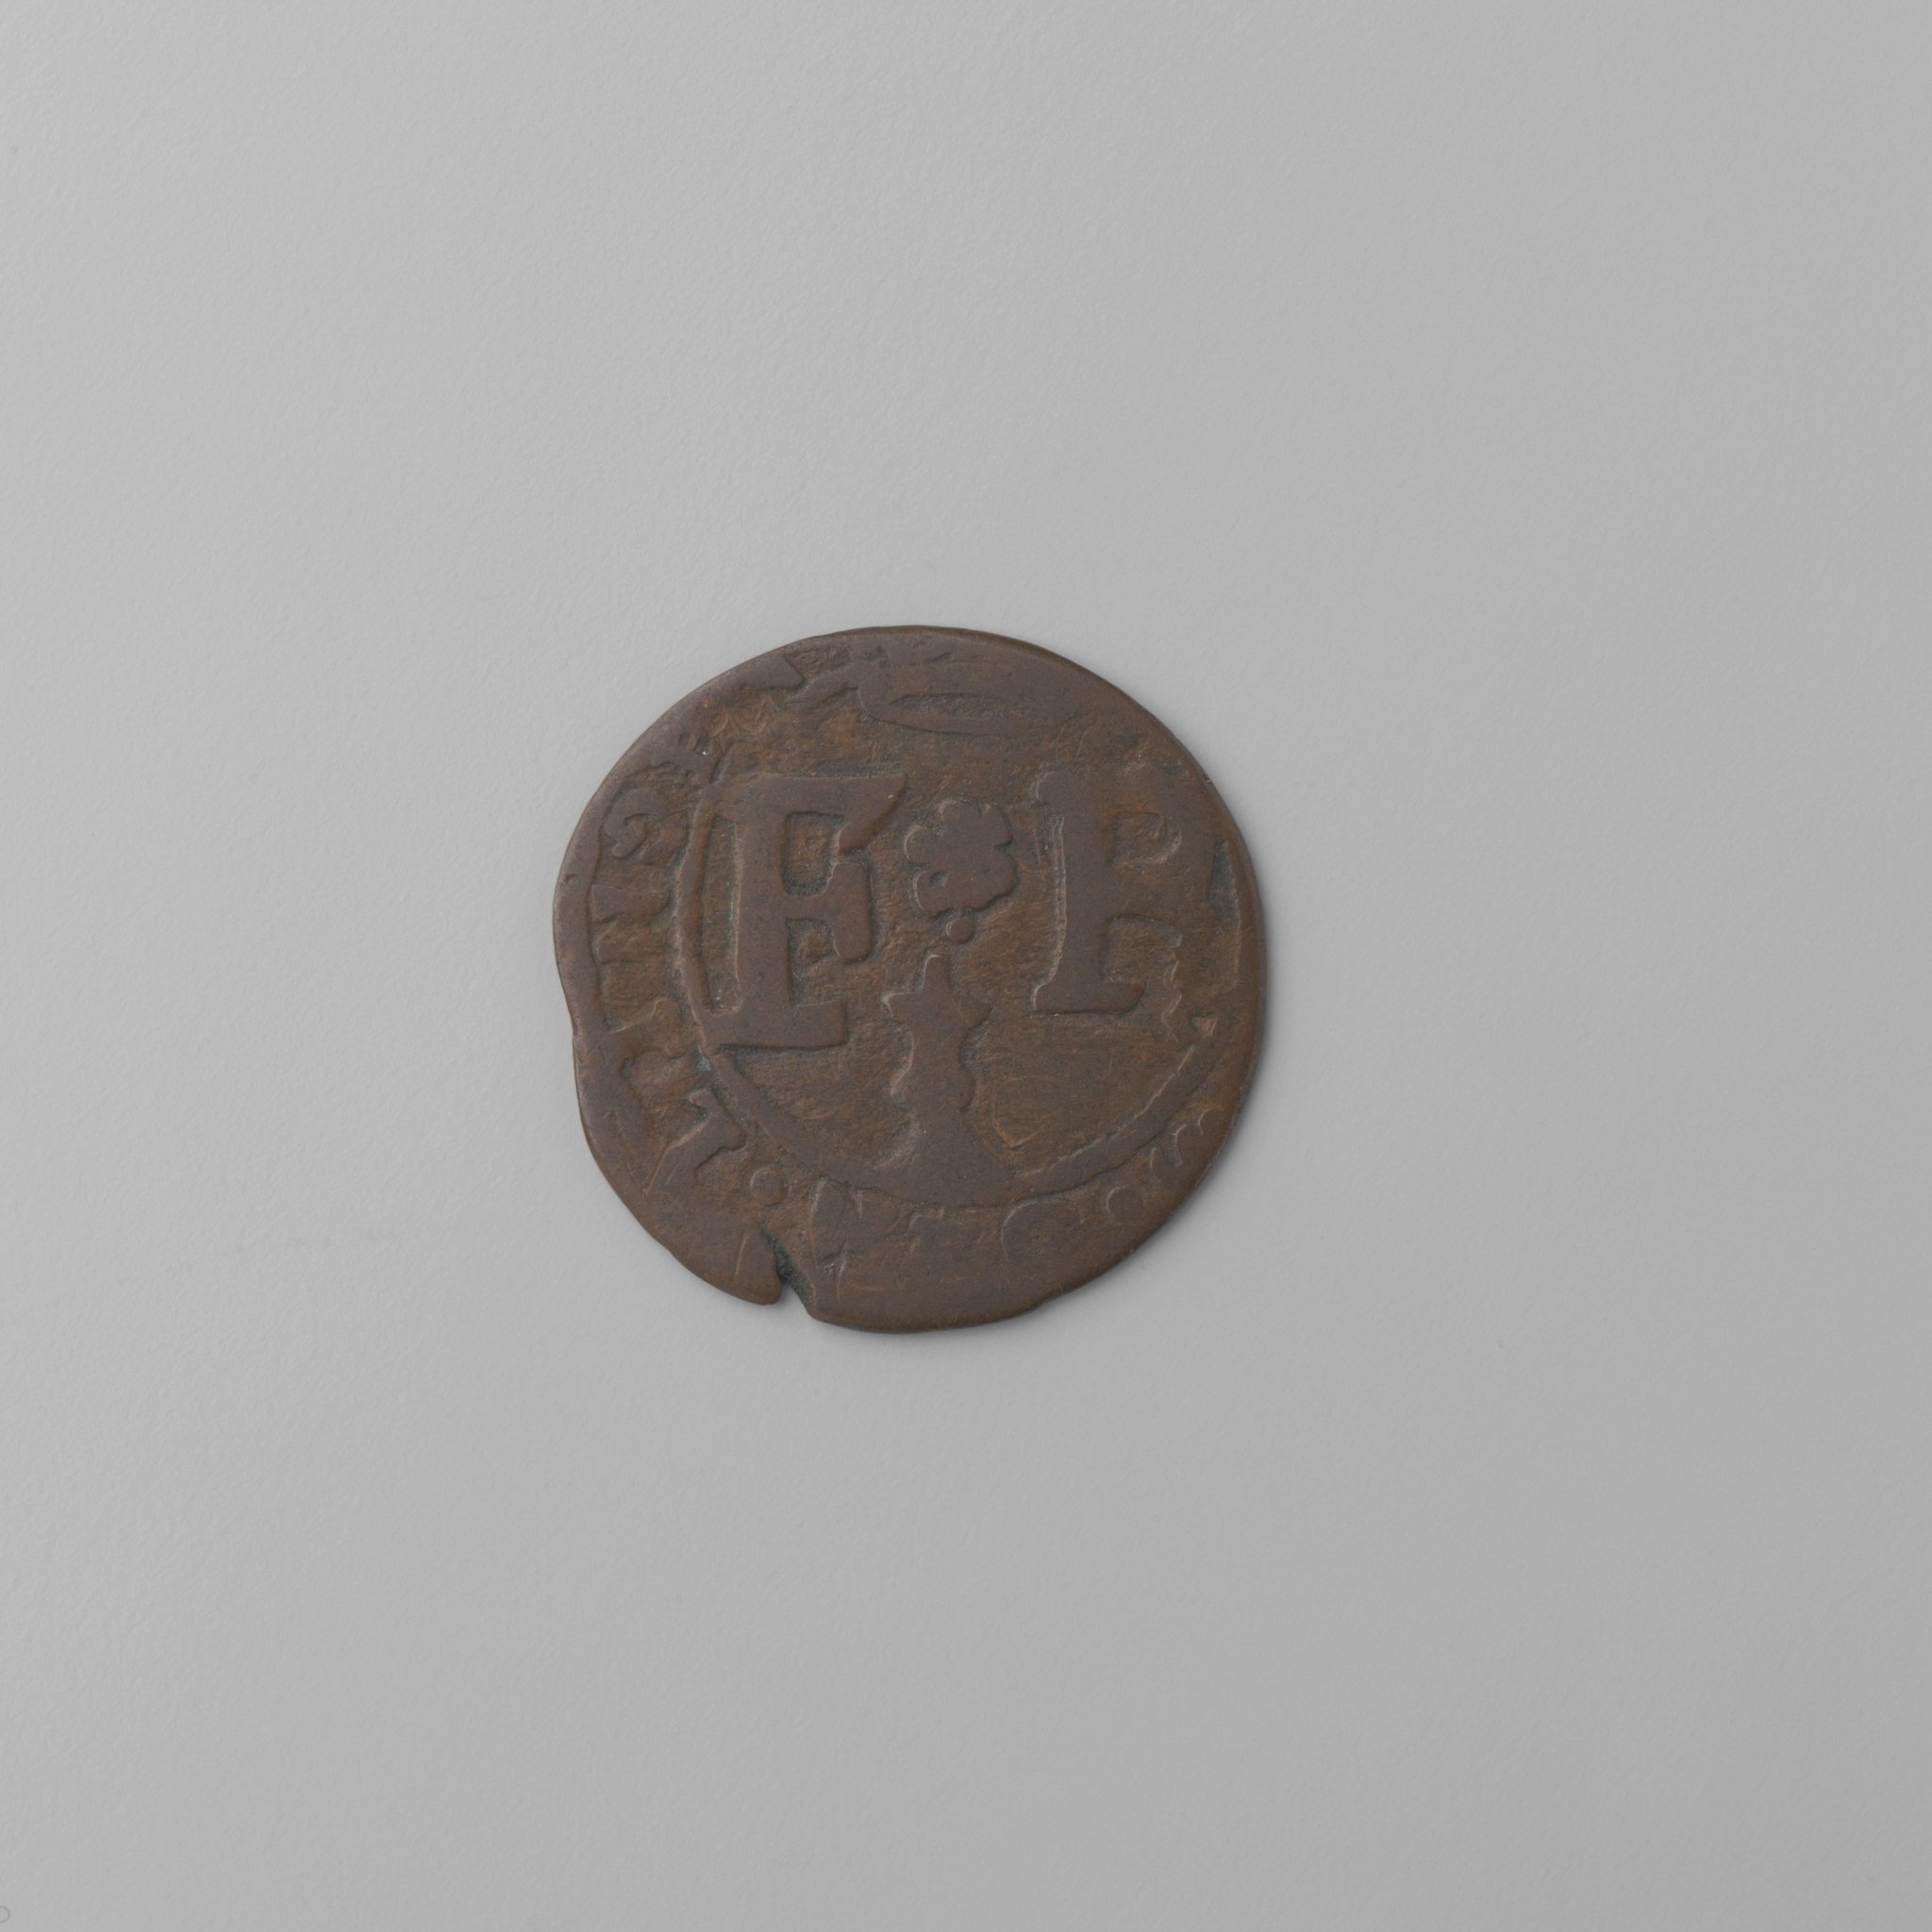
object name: oord, oortje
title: Reckheimse oord van Ferdinand van Aspremont-Lynden (1636-1665)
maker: heer van reckheim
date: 1636-1665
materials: copper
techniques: striking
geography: rekem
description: Koperen munt. Voorzijde: gekroond wapenschild. Keerzijde: onder een kroon de letters F en R. Daaronder een perron.